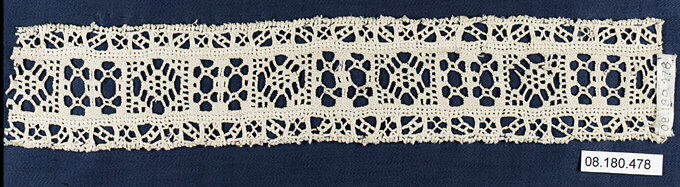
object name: band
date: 1601-1700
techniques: lace